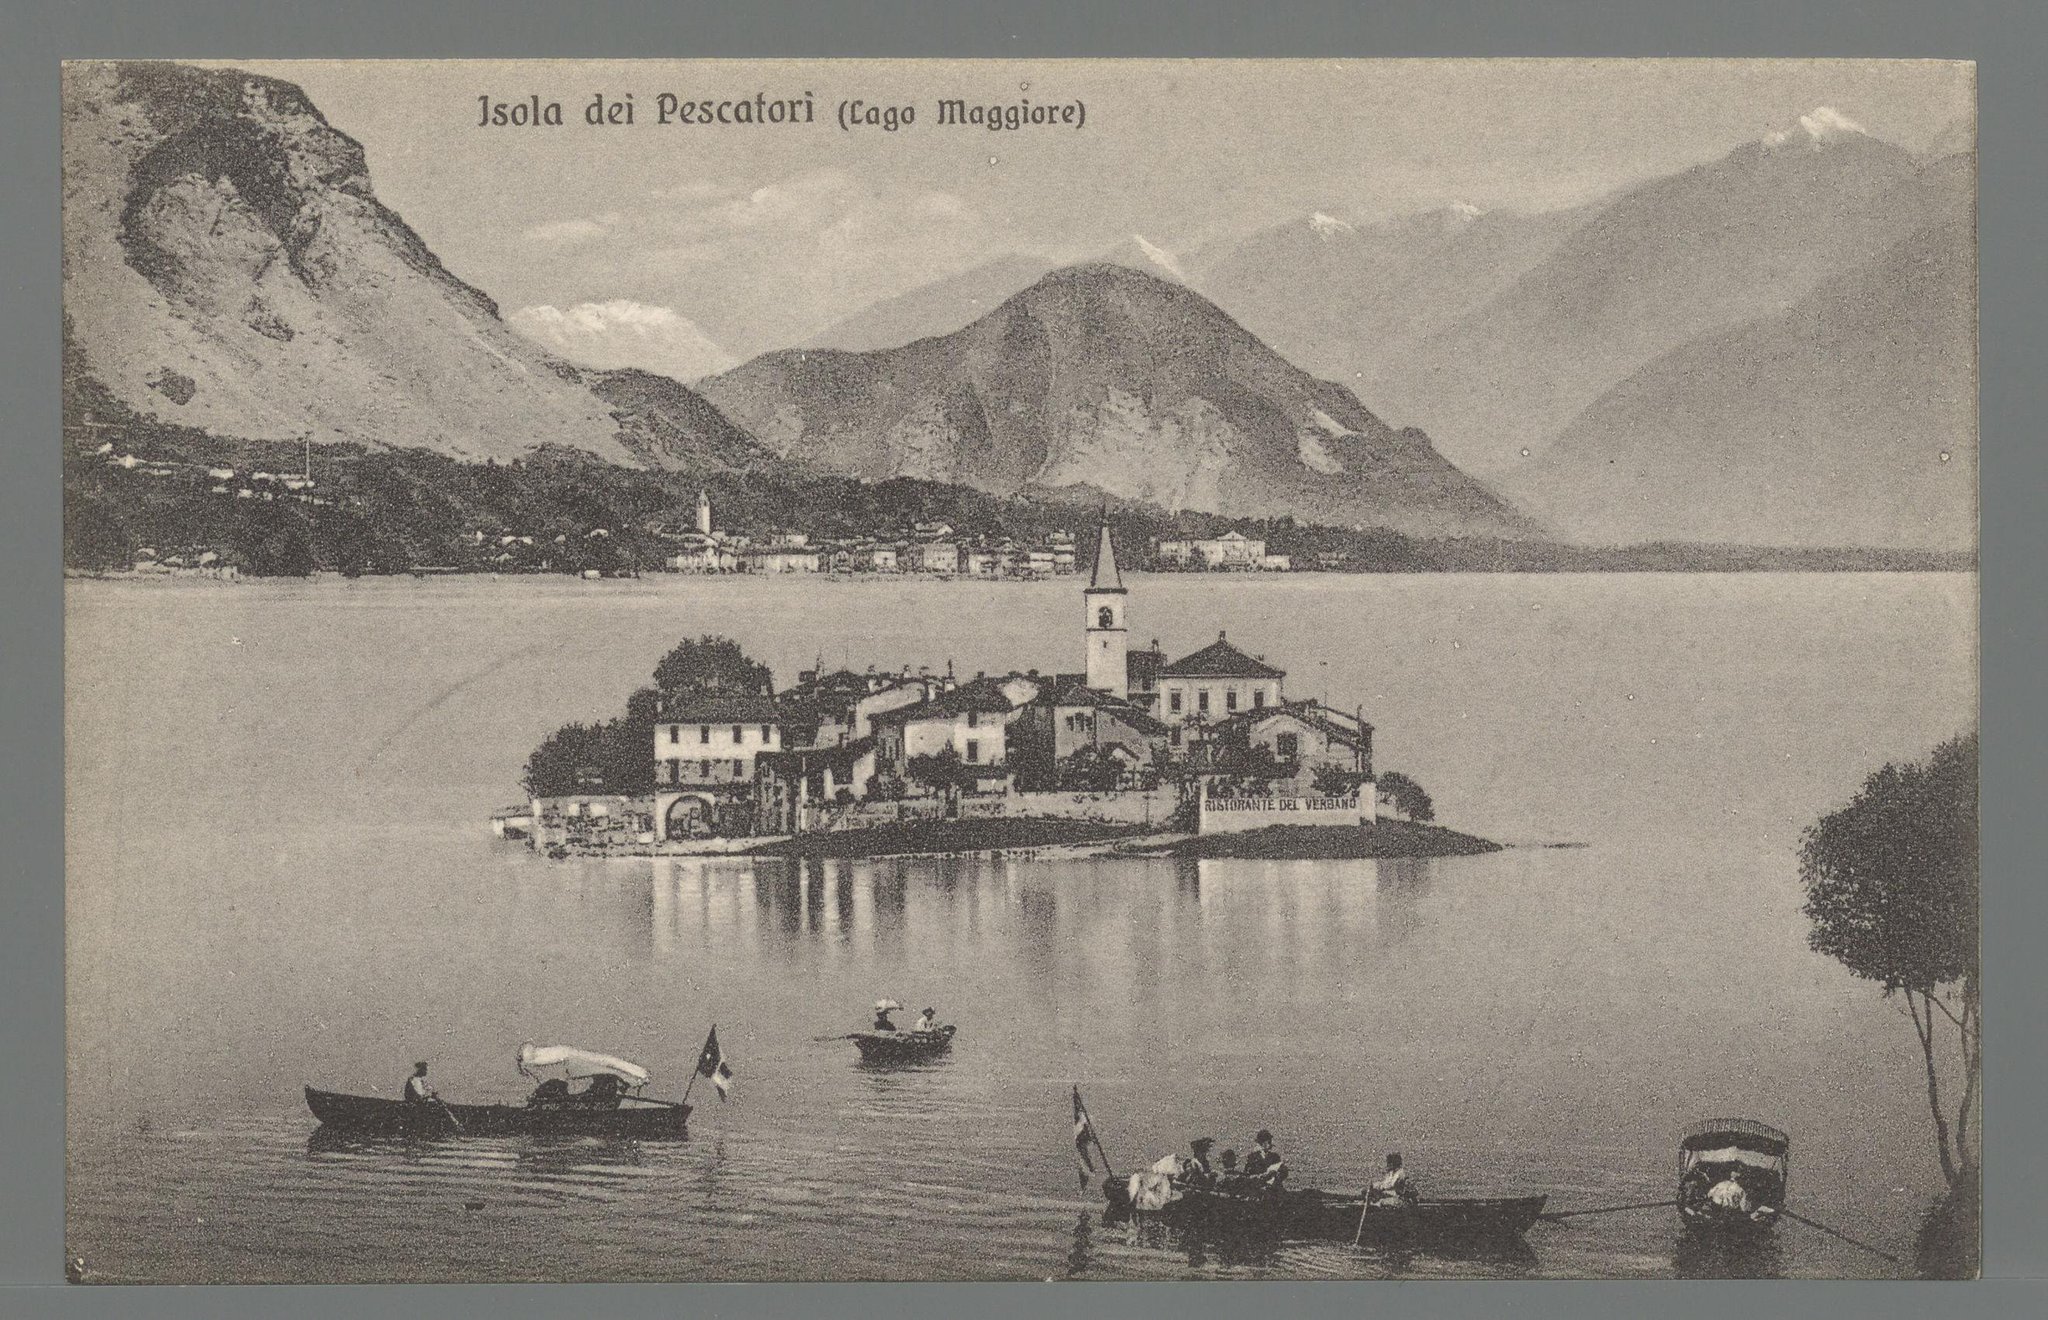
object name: photomechanical print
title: Isola dei Pescatori (Lago Maggiore)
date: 1905-1909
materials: cardboard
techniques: photograph, writing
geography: como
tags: island, lake, mountains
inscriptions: monogram: ‘S.G.’